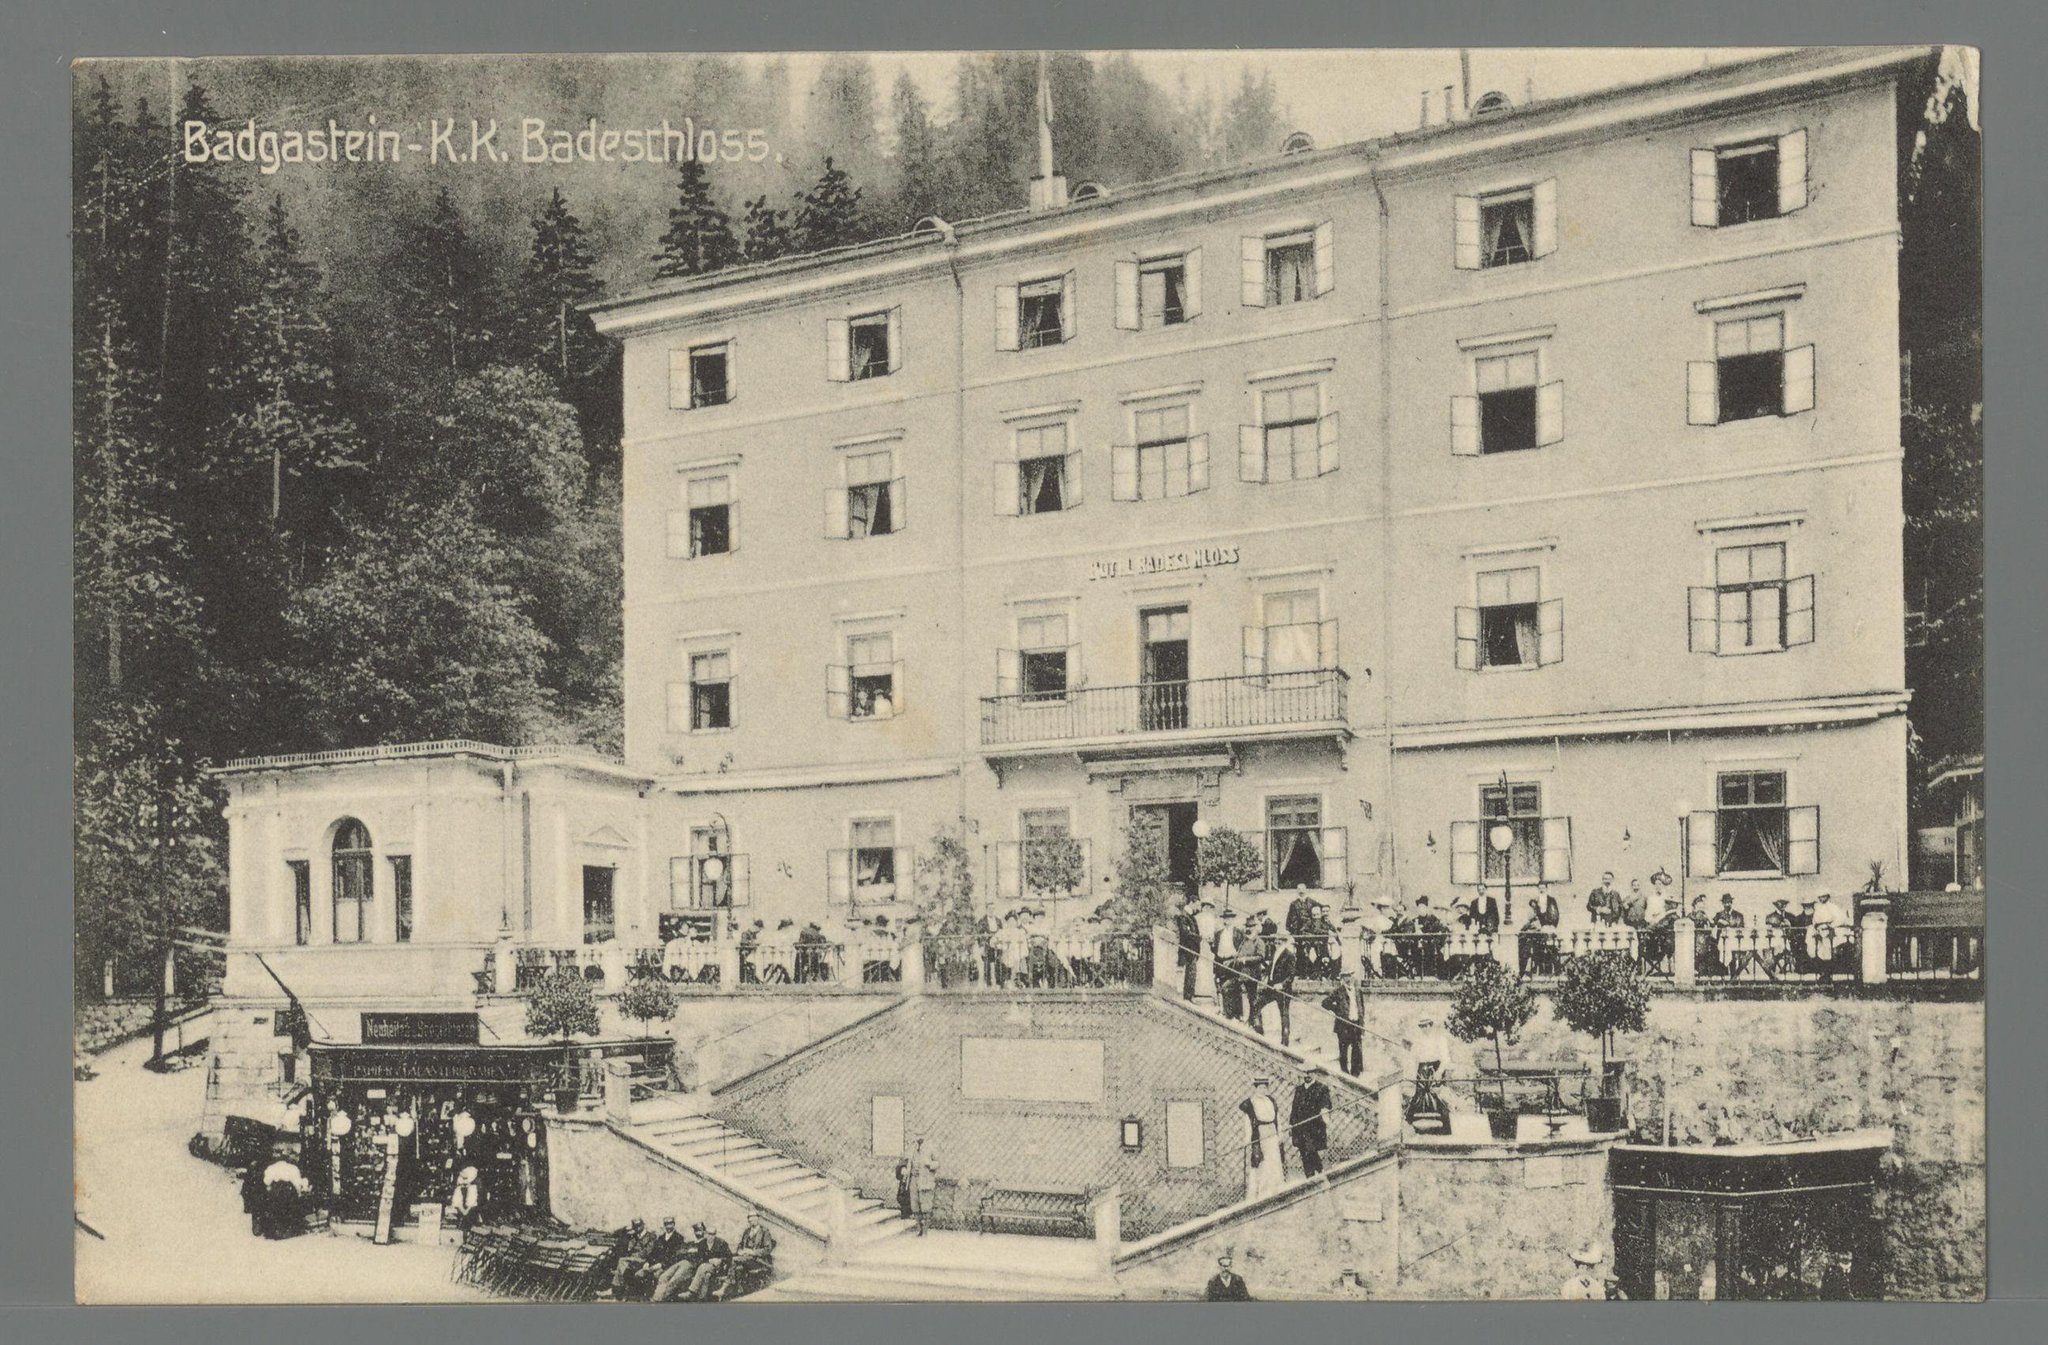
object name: photomechanical print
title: Badgastein - K.K. Badeschloss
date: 1904-1909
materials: cardboard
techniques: photograph, writing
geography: bad gastein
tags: watering-place, spa, hotel, hostelry, inn